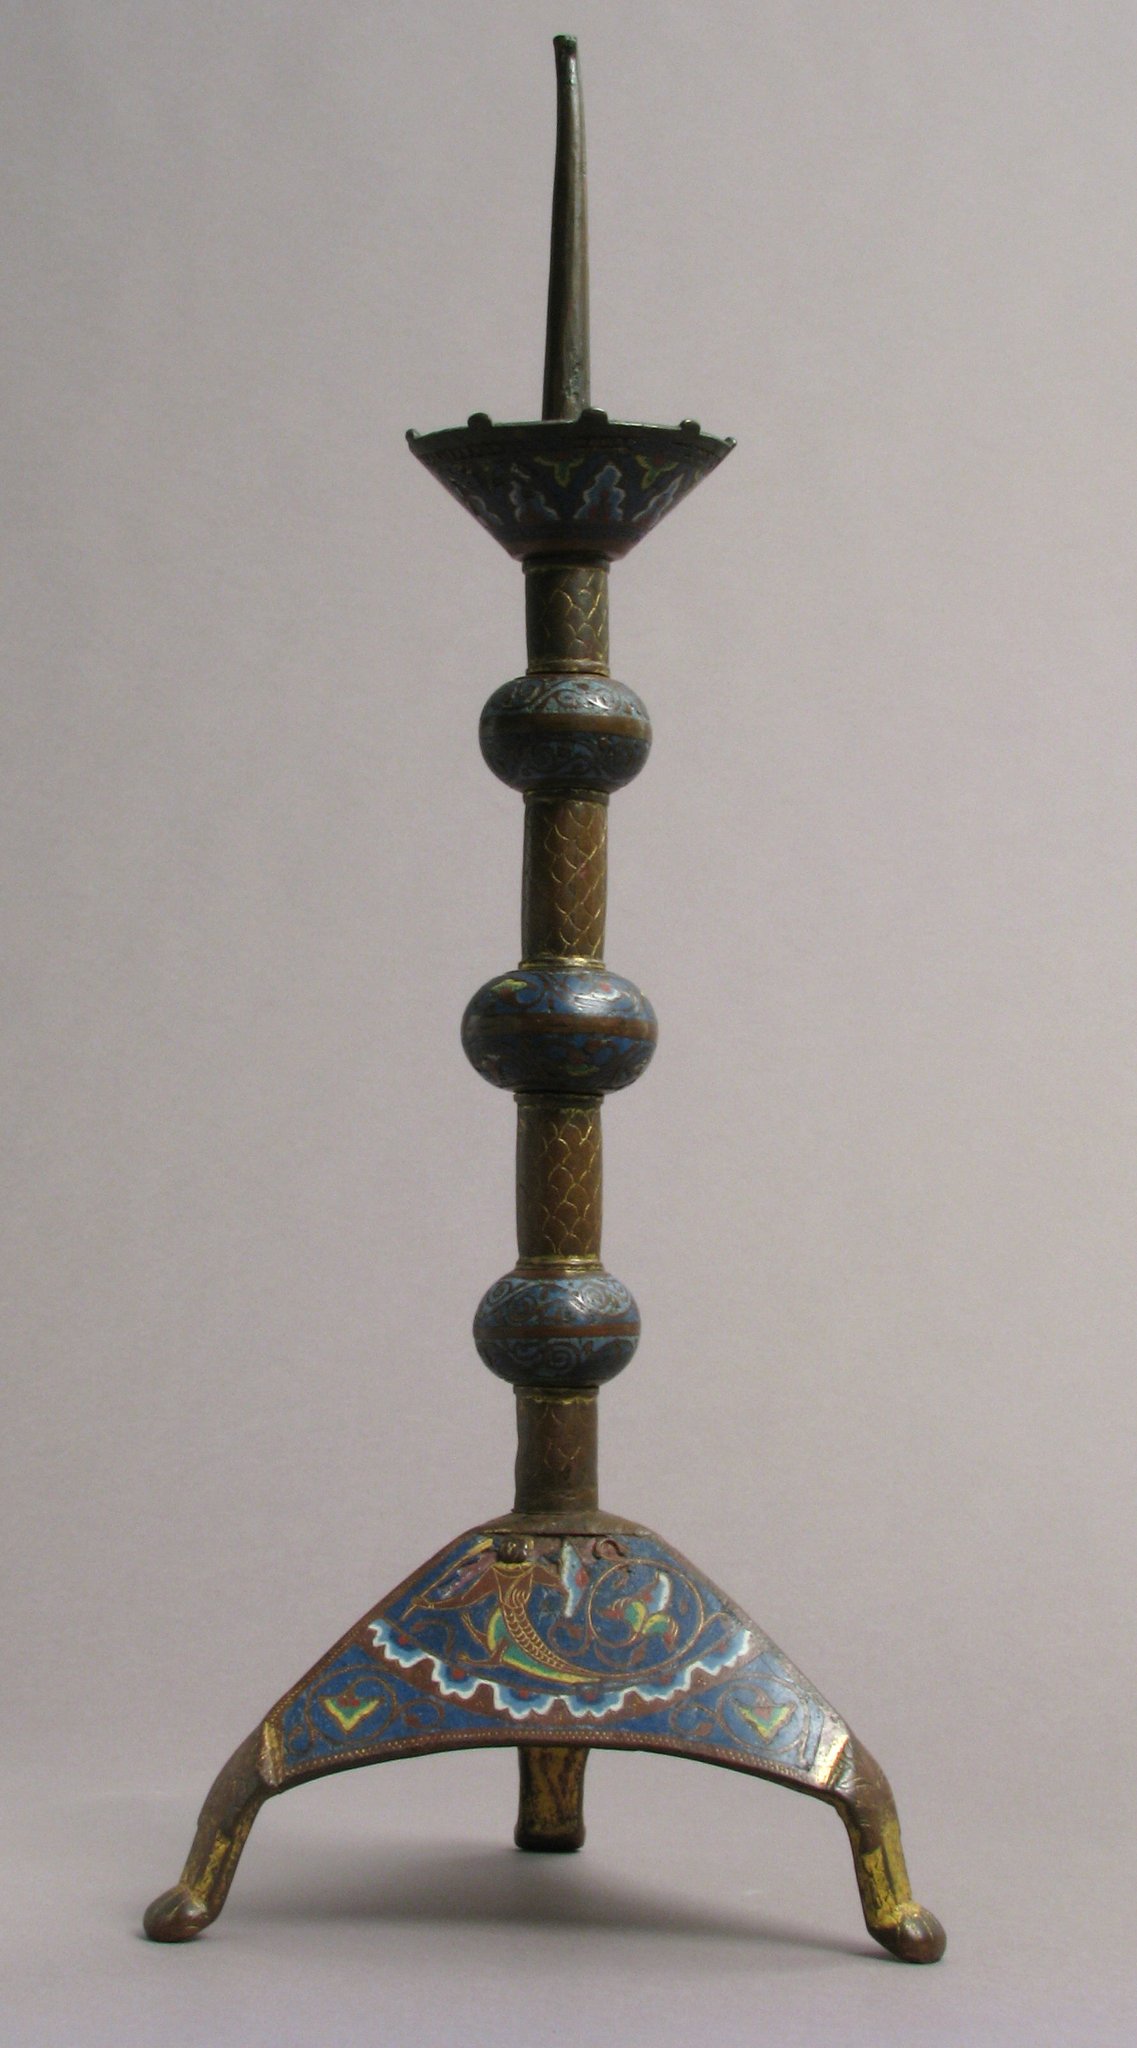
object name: candlestick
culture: french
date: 1190-1200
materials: copper, enamel, gilt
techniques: enamel, engraving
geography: france